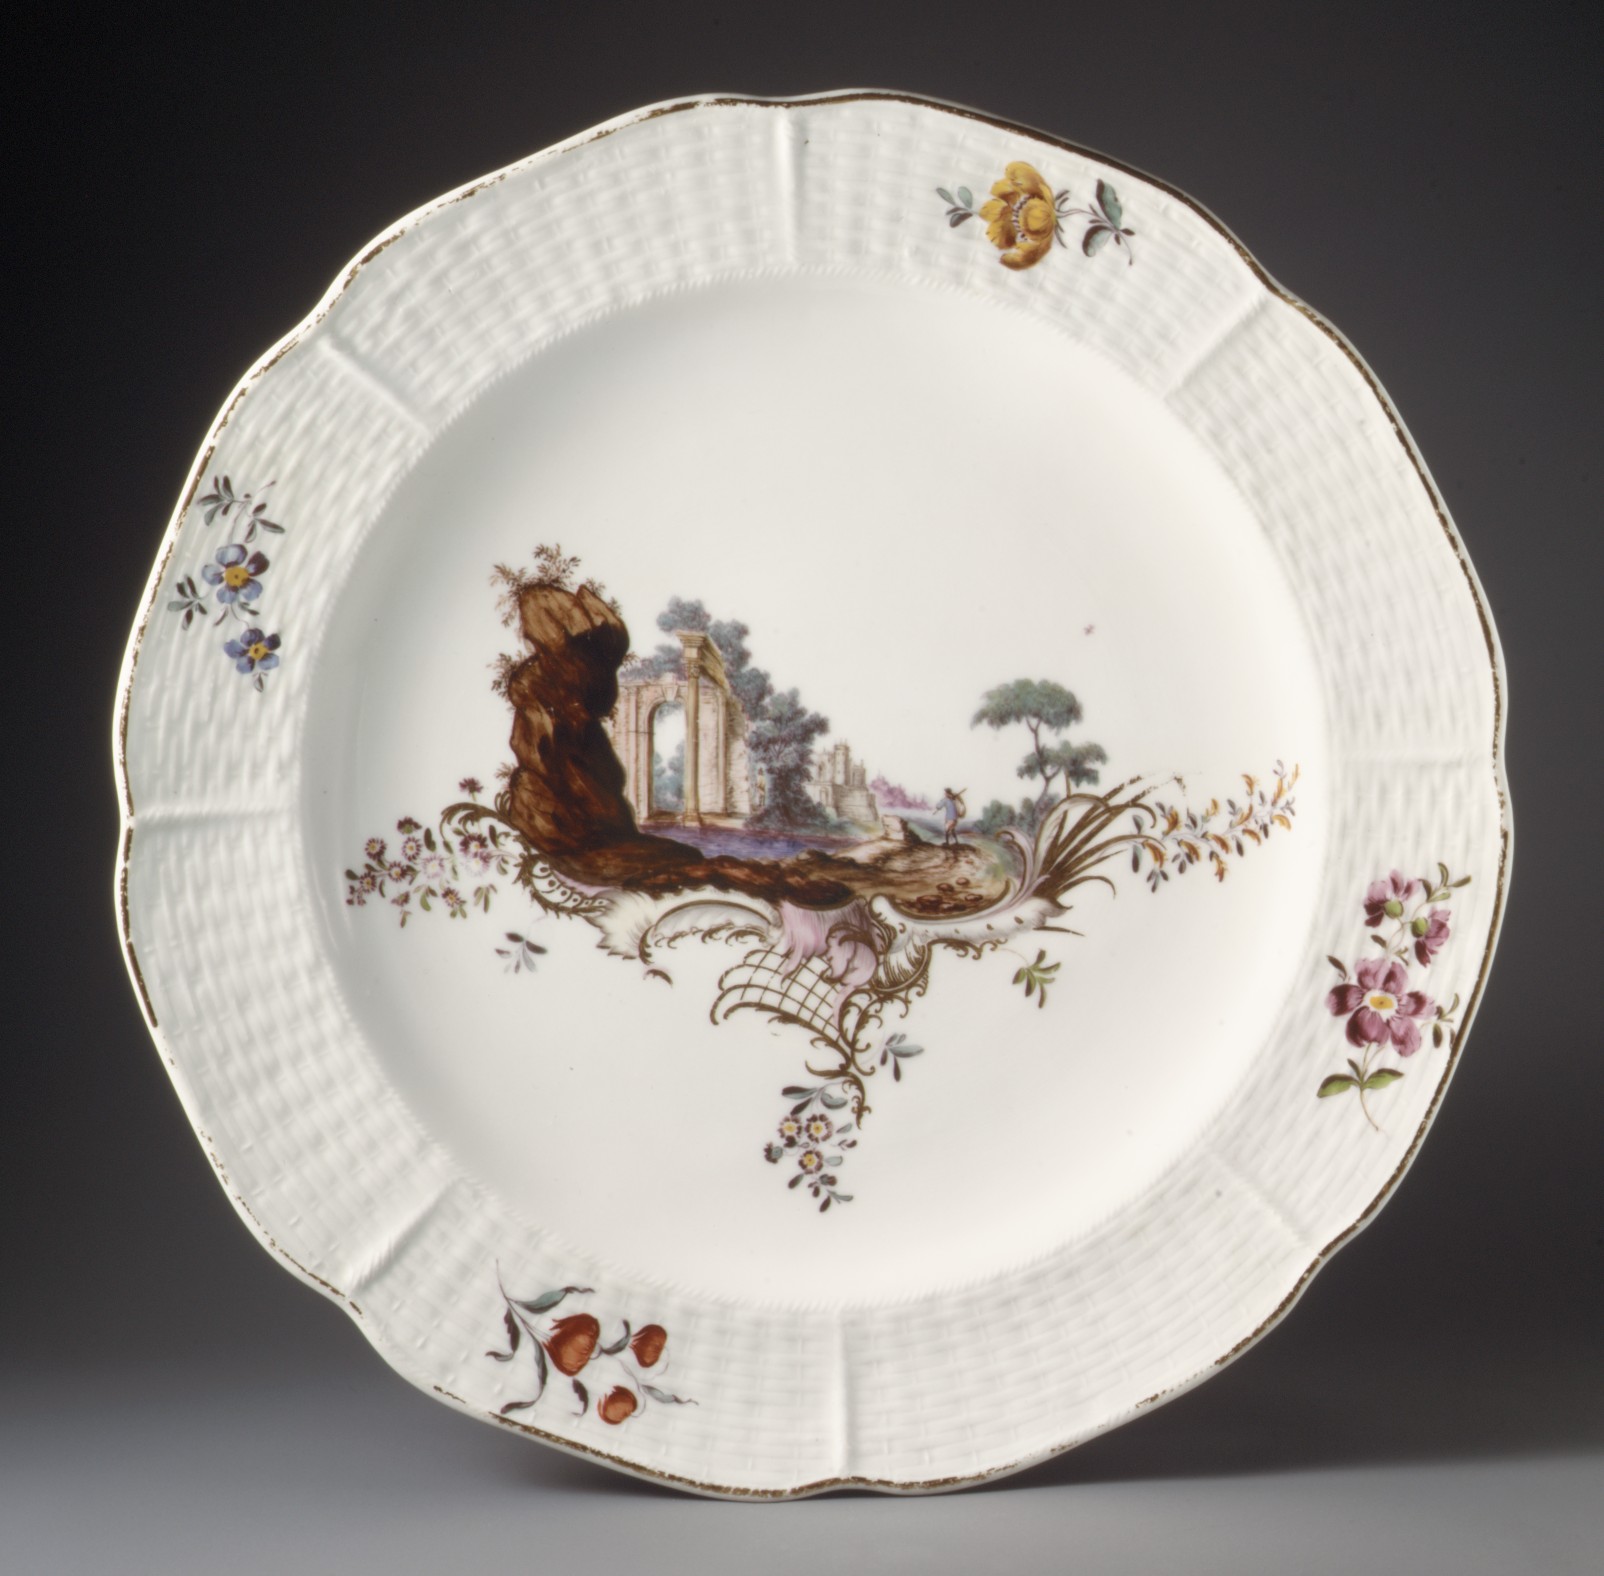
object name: plate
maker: frankenthal porcelain manufactory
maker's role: manufactory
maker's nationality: german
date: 1755-1759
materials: hard paste porcelain